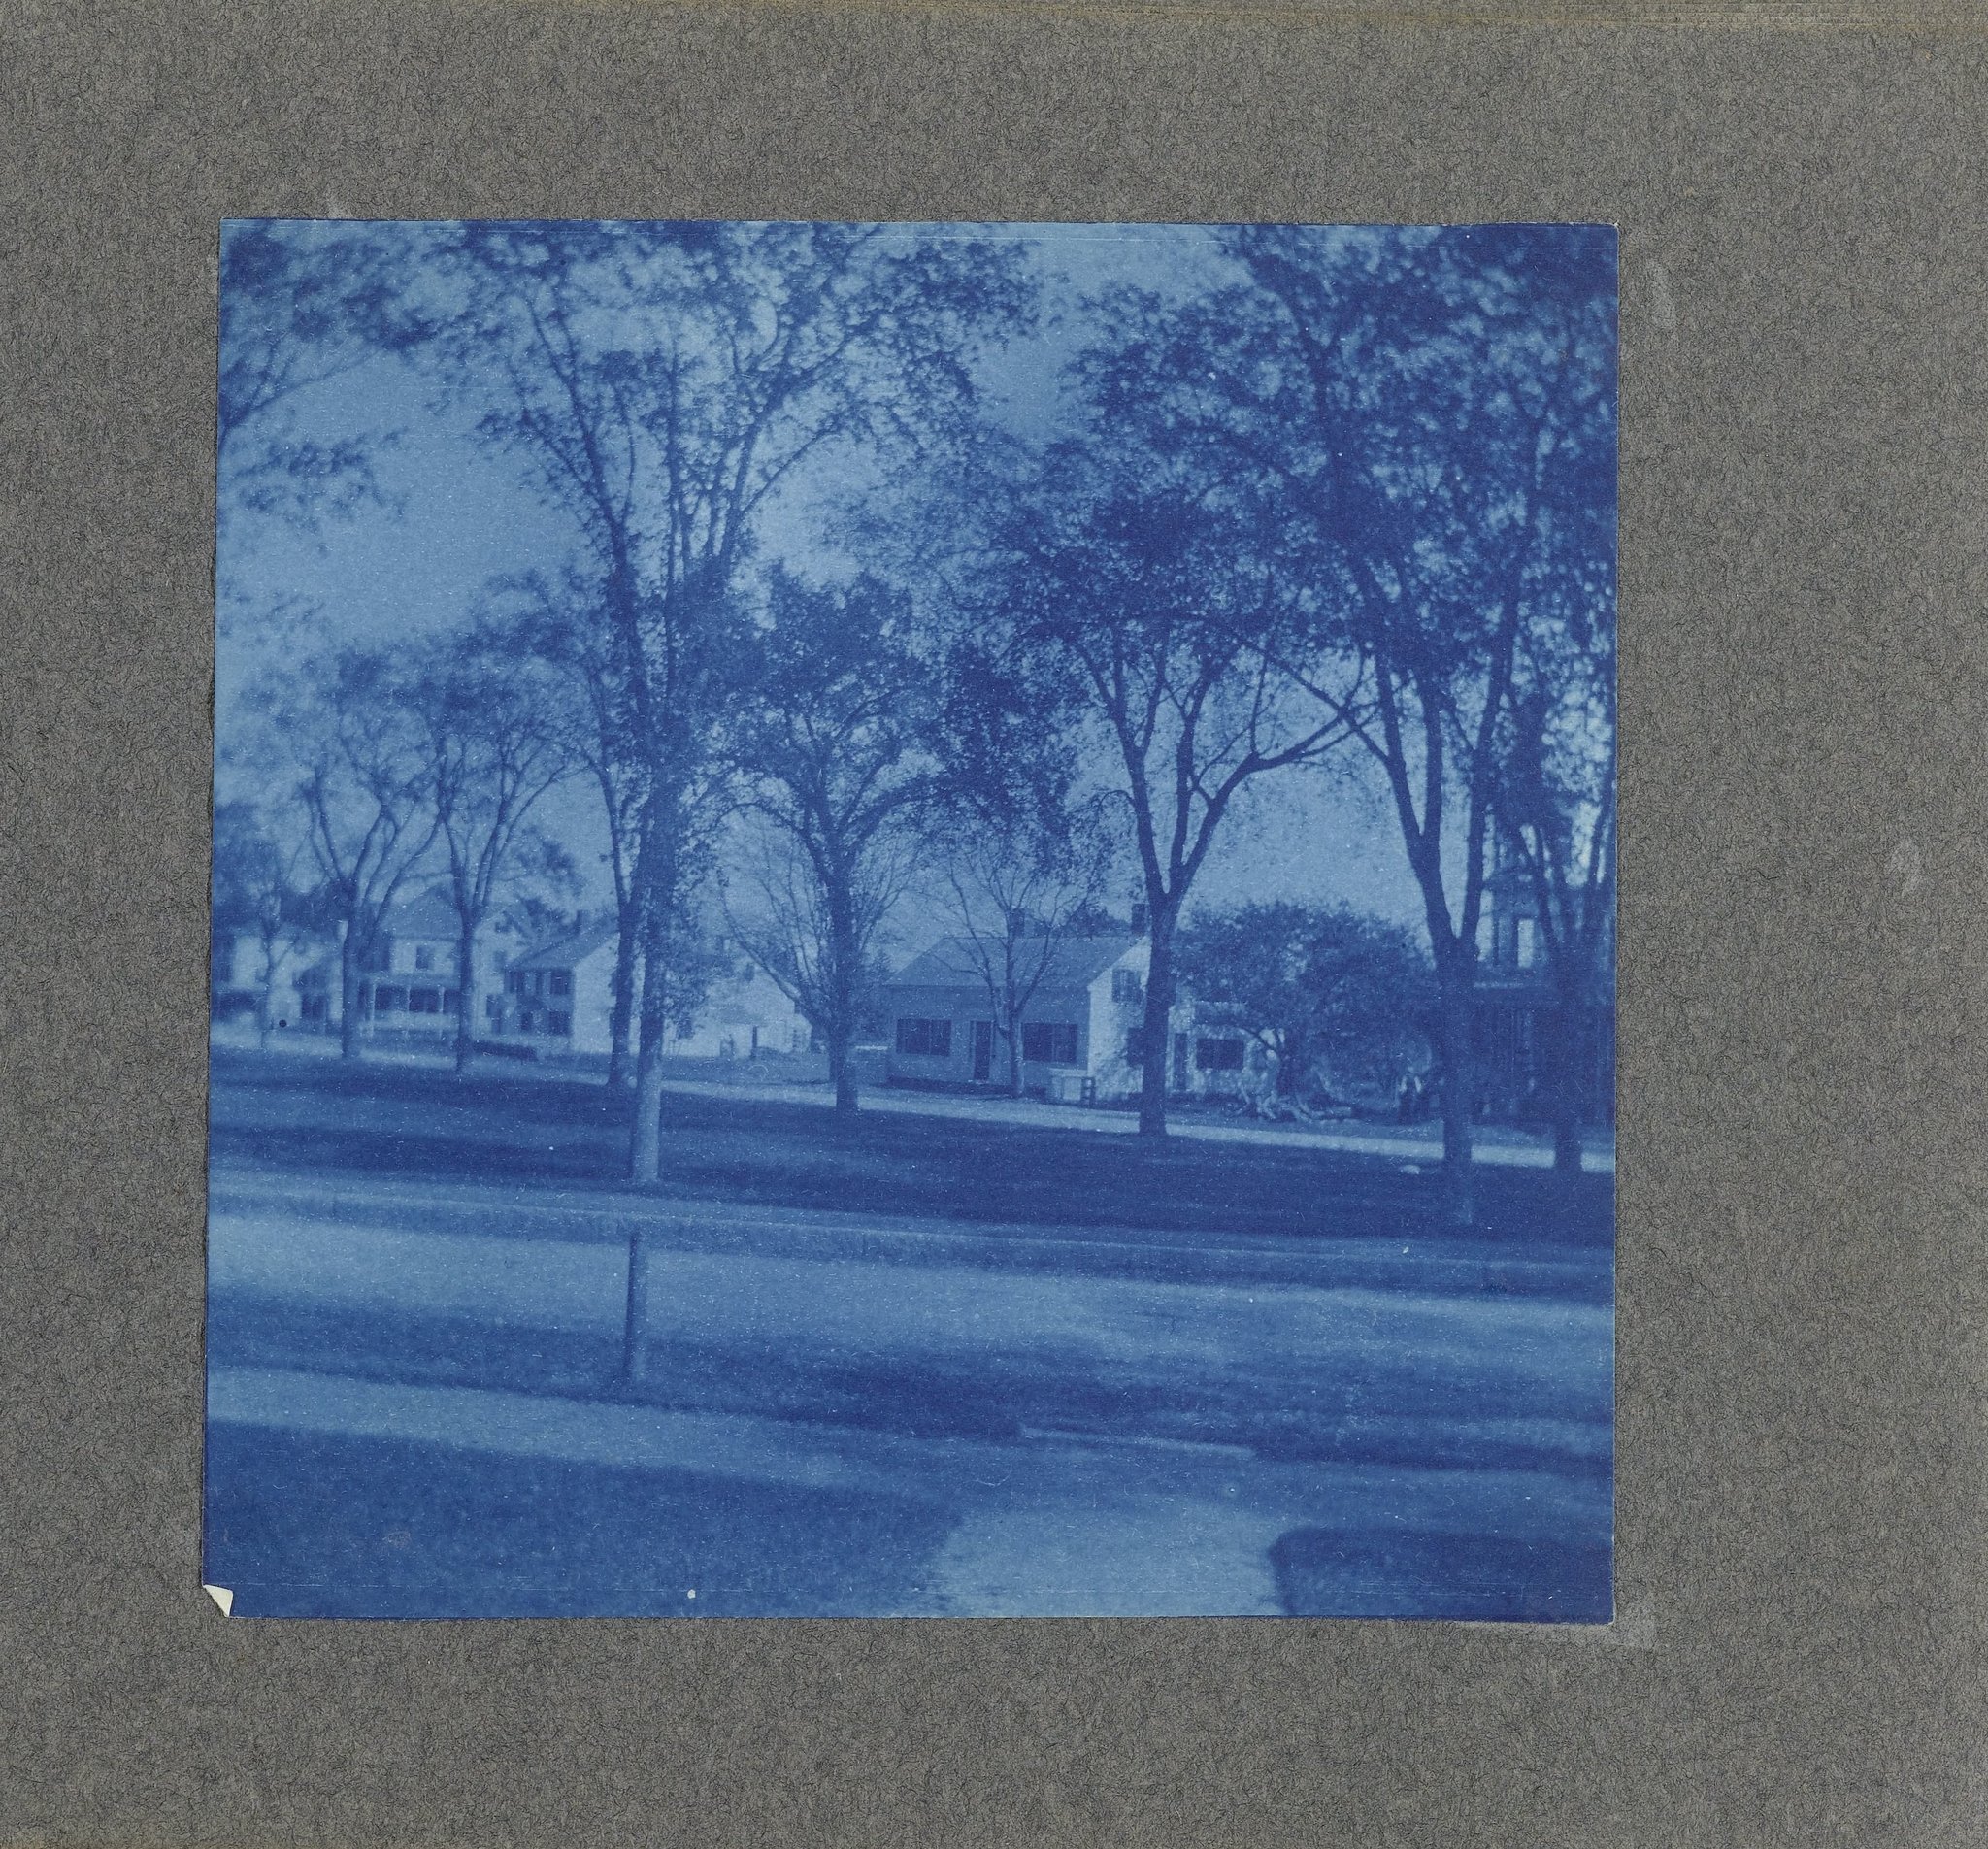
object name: photograph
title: Houten huizen bij bomen, Verenigde Staten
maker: Anonymous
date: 1900-1920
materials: paper, photographic support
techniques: cyanotype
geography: united states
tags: trees, country-house, united states of america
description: Onderdeel van Fotoalbum met 53 cyanotypieën van kinderen, paarden, huizen, boten en strandtaferelen in de Verenigde Staten.